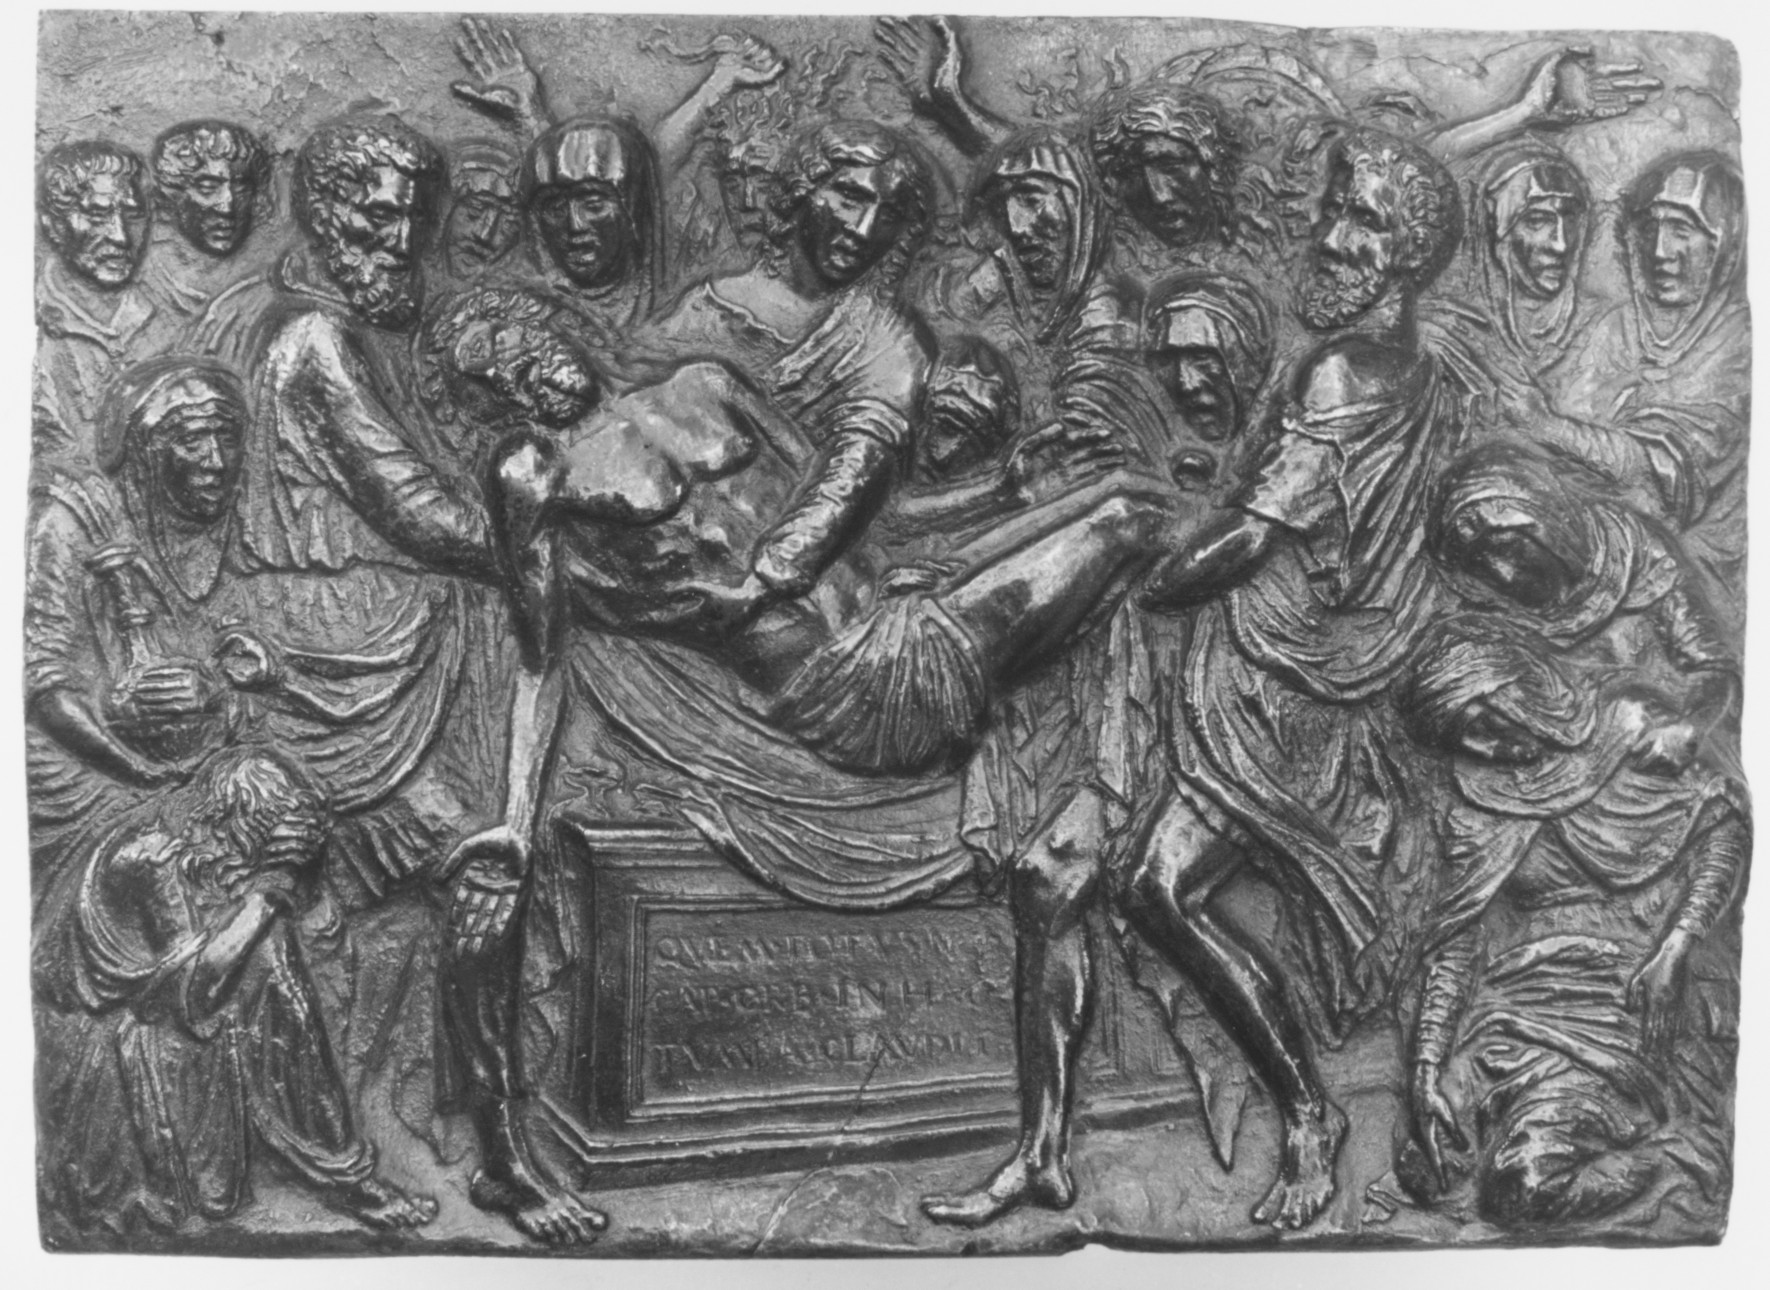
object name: plaquette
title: The Entombment of Christ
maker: andrea briosco, called riccio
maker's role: artist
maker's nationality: italian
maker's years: 1470-1532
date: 1501-1533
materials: bronze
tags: sadness,christ,entombment